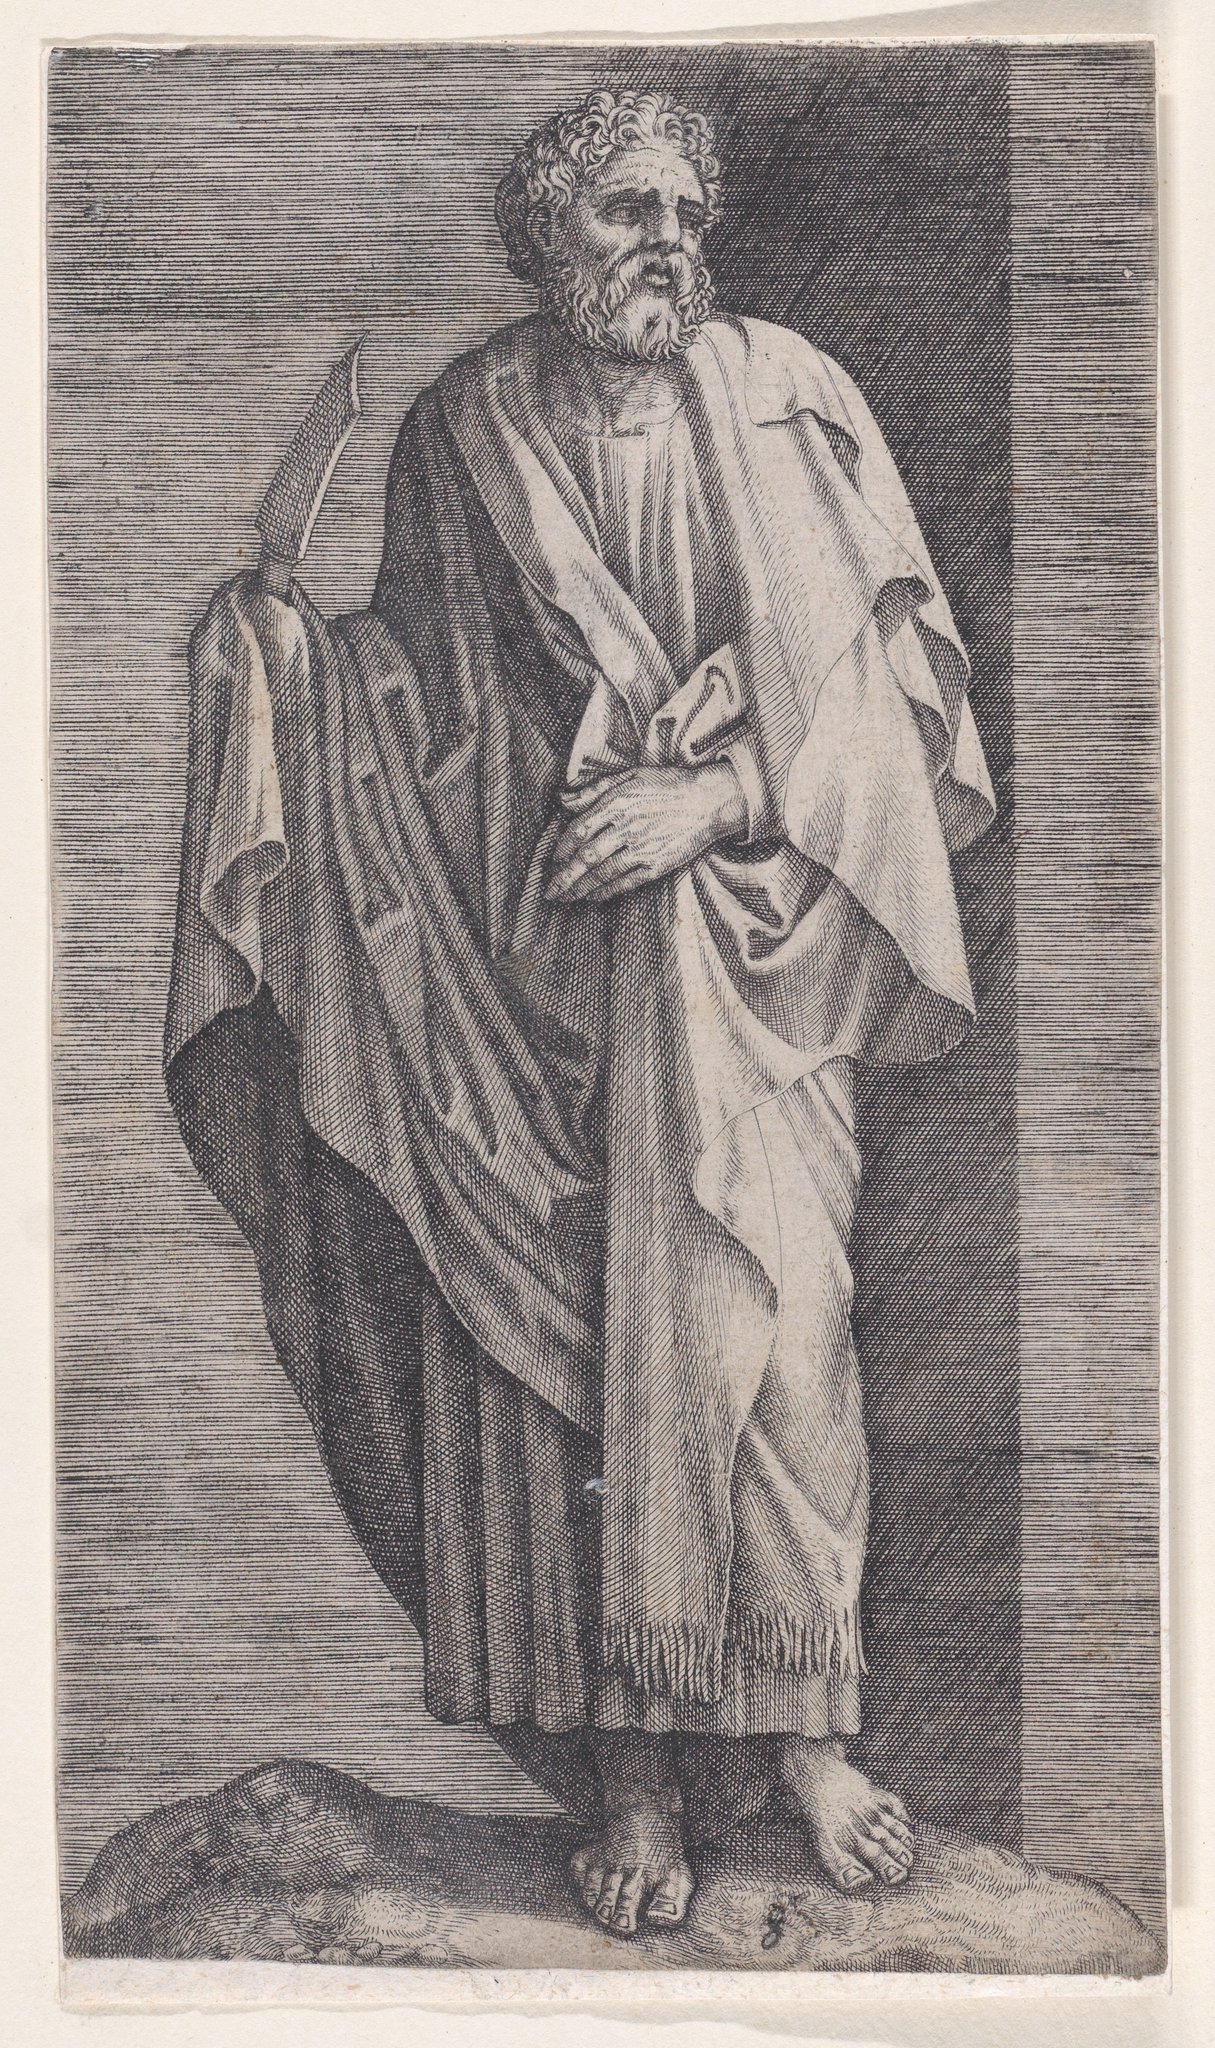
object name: print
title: St. Bartholomew, from "Christ and the Apostles"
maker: lambert suavius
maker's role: artist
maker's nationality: netherlandish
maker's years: 1510-1576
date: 1530-1576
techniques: backing, engraving